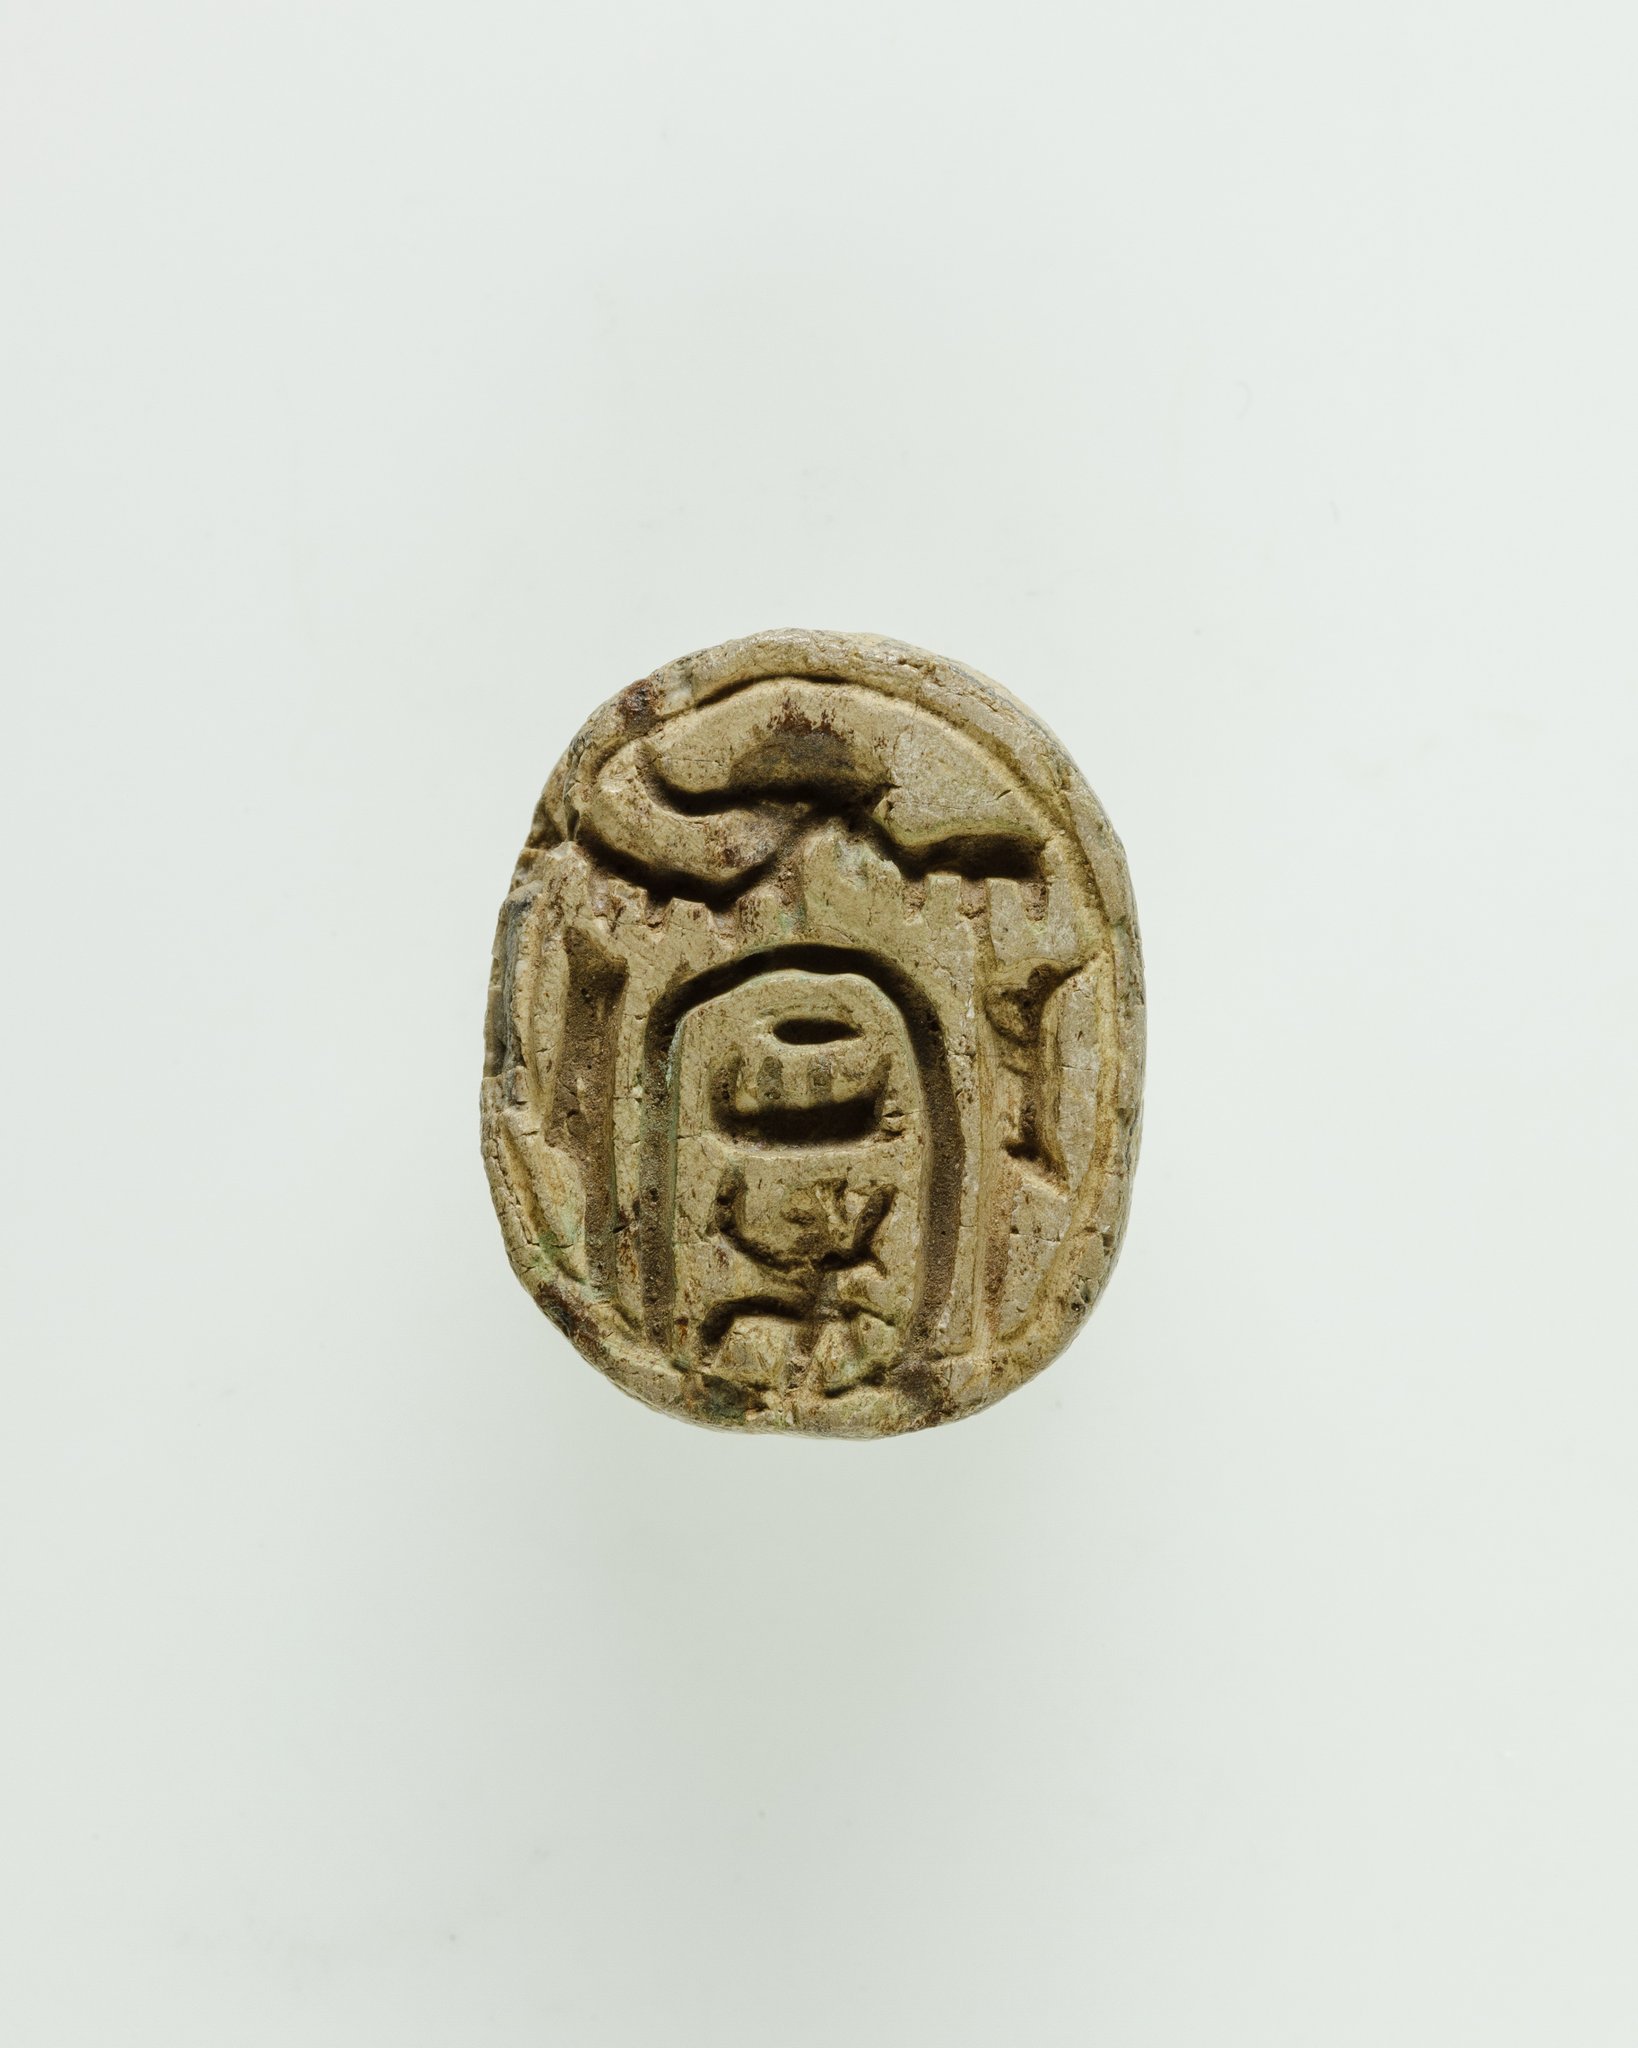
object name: scarab, hieroglyph, menkheperre, winged sun disk ostrich feather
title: Scarab inscribed with the name Menkheperre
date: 1186-945 BCE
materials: glaze, stone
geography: egypt